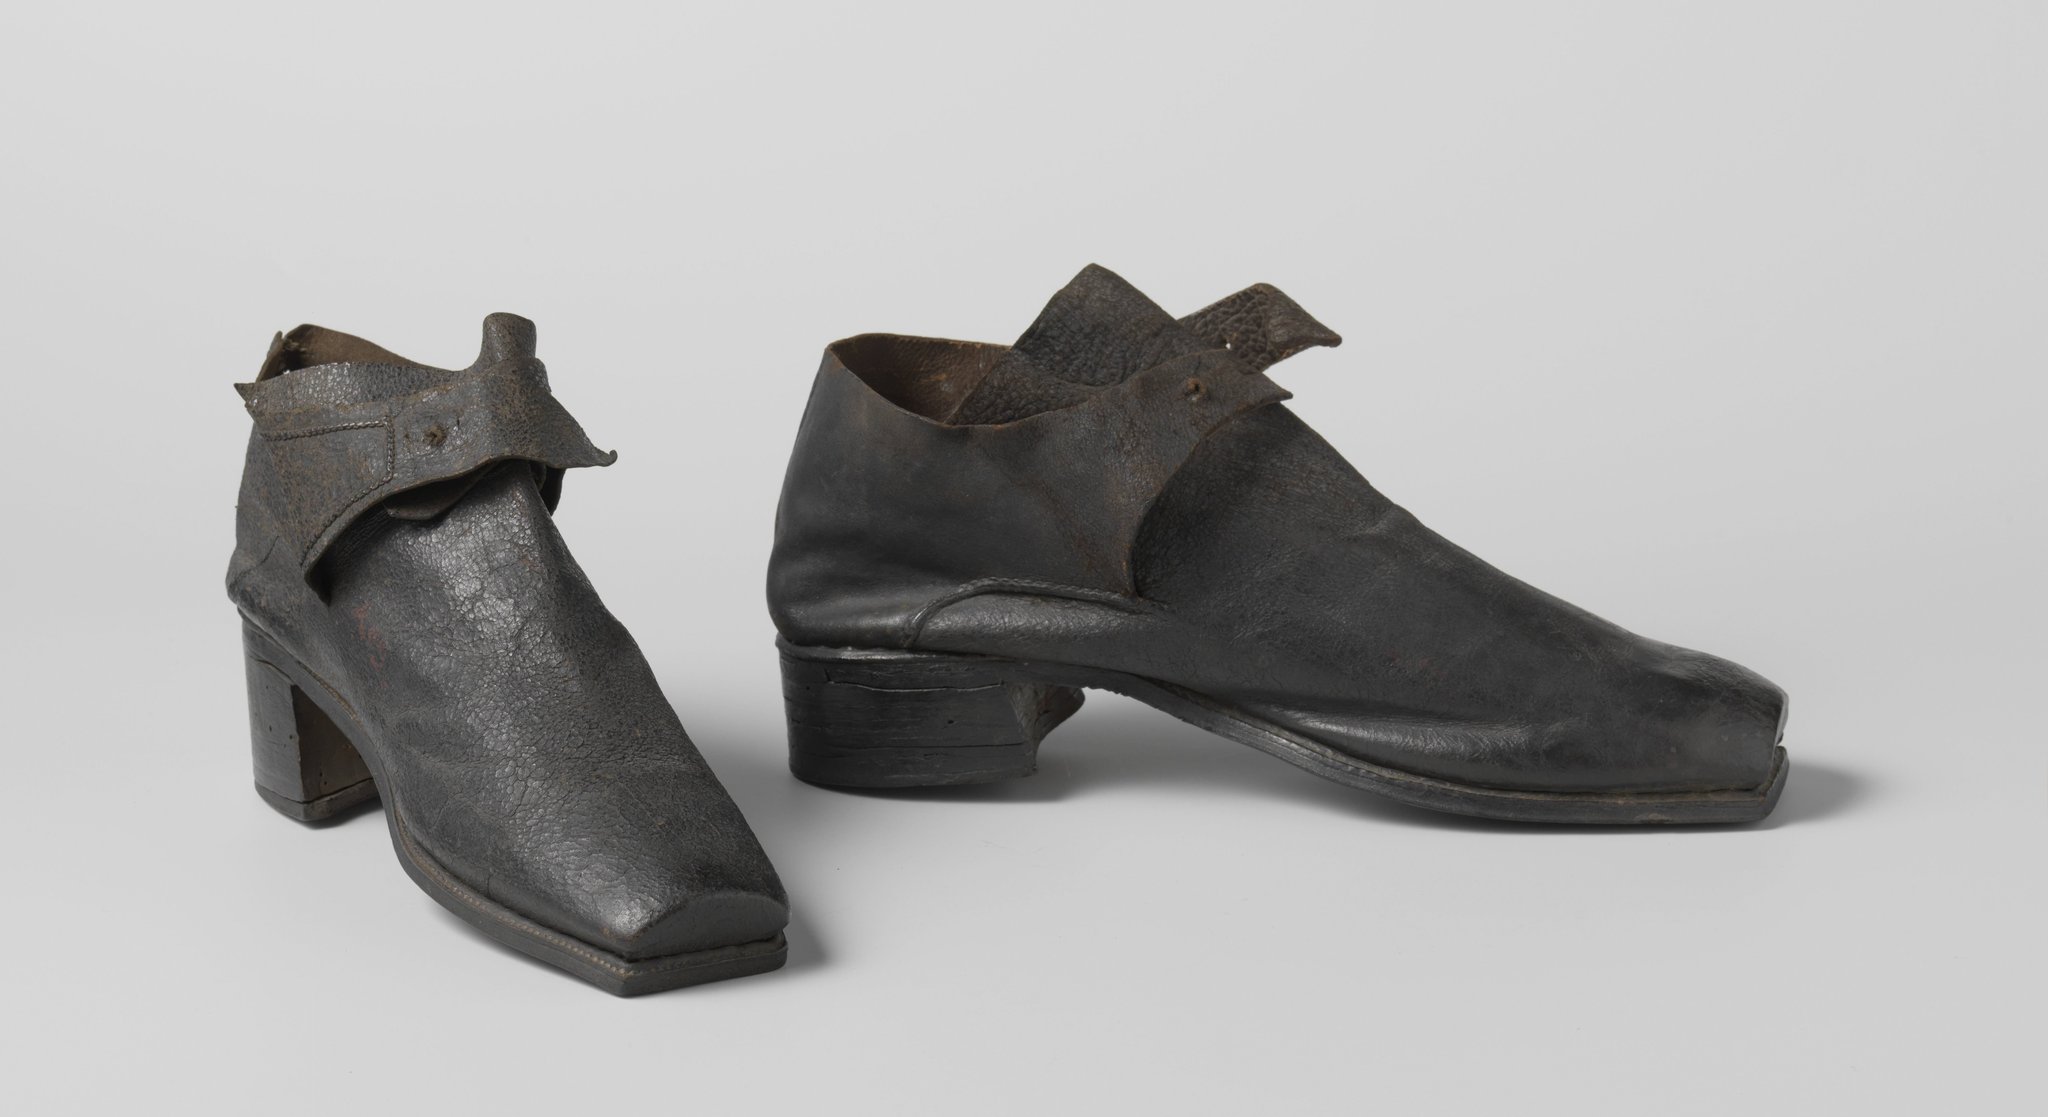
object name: clothing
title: Schoenen van zwart leer met een afgeplatte, vierkante neus, een hoog voorblad waarover twee sluitriemen en een vierkante hak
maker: Anonymous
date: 1690-1700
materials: leather, wood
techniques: sewing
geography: northern netherlands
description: Twee schoenen (géén paar) van zwart leer met een afgeplatte, vierkante neus, een hoog voorblad waarover twee sluitriemen en een vierkante hak. De zool en de bovenkant zijn met touw aan elkaar genaaid. De neus steekt een klein stukje over de zool uit: kenmerkend voor de schoenen aan het einde van de 17de eeuw.